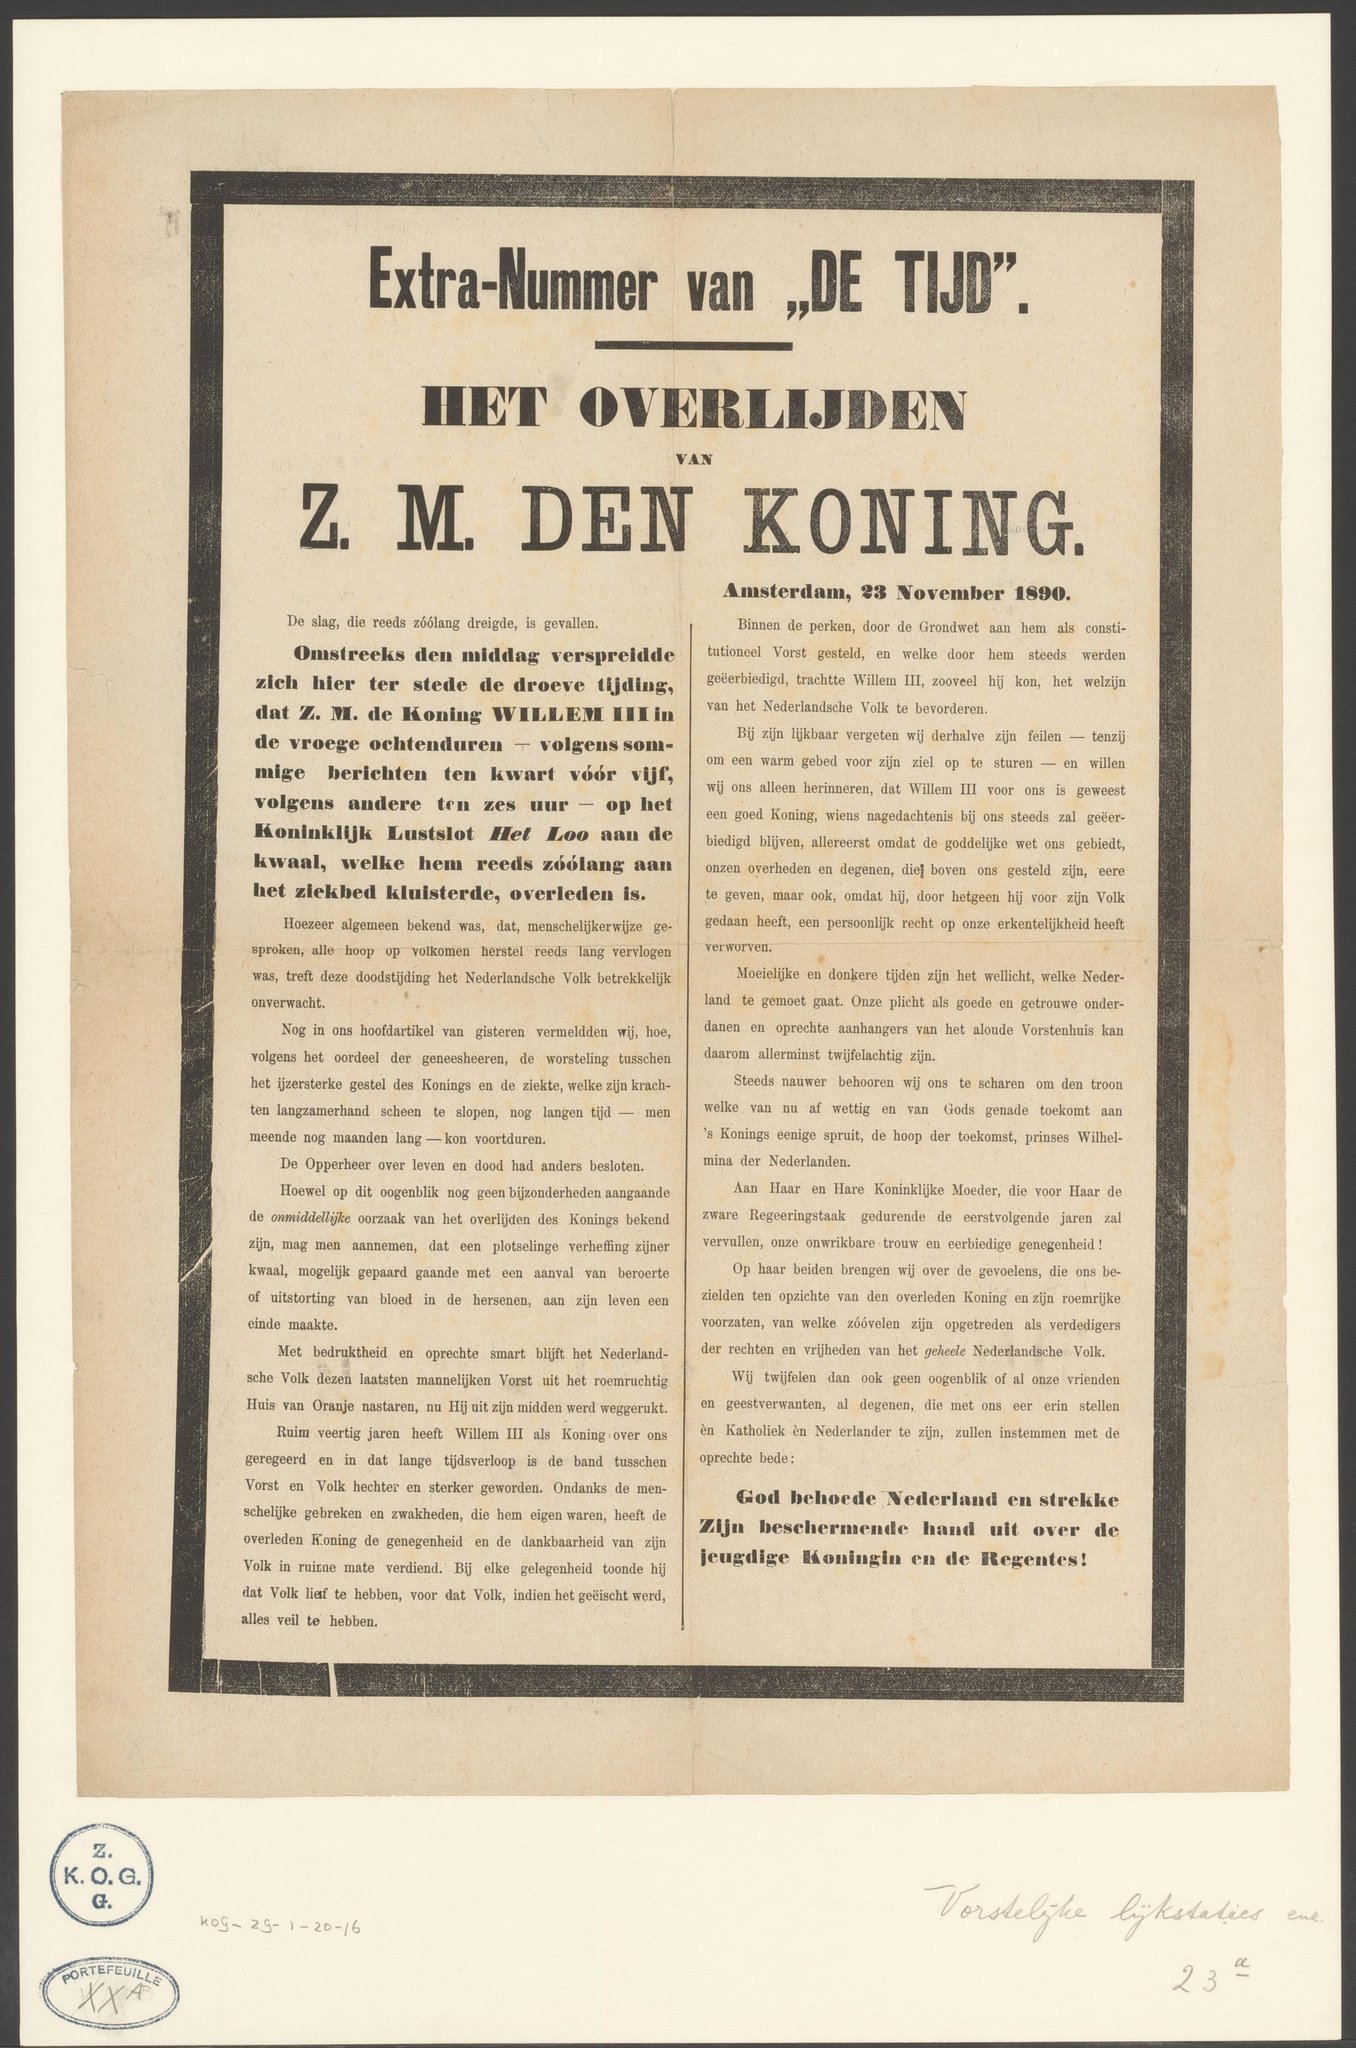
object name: text sheet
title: Overlijdensbericht van Willem III, koning der Nederlanden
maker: Anonymous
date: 1890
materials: paper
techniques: letterpress printing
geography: amsterdam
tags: brussels, willem iii (koning der nederlanden)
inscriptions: collector's mark: Lugt 1641, stamp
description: Onderwerpsrubrieken binnen de Atlas Zeden en Gewoonten: Zeden en Gewoonten in Engeren Zin, Des menschen beging, midden en einde, Vorstelijke lijkstaties.